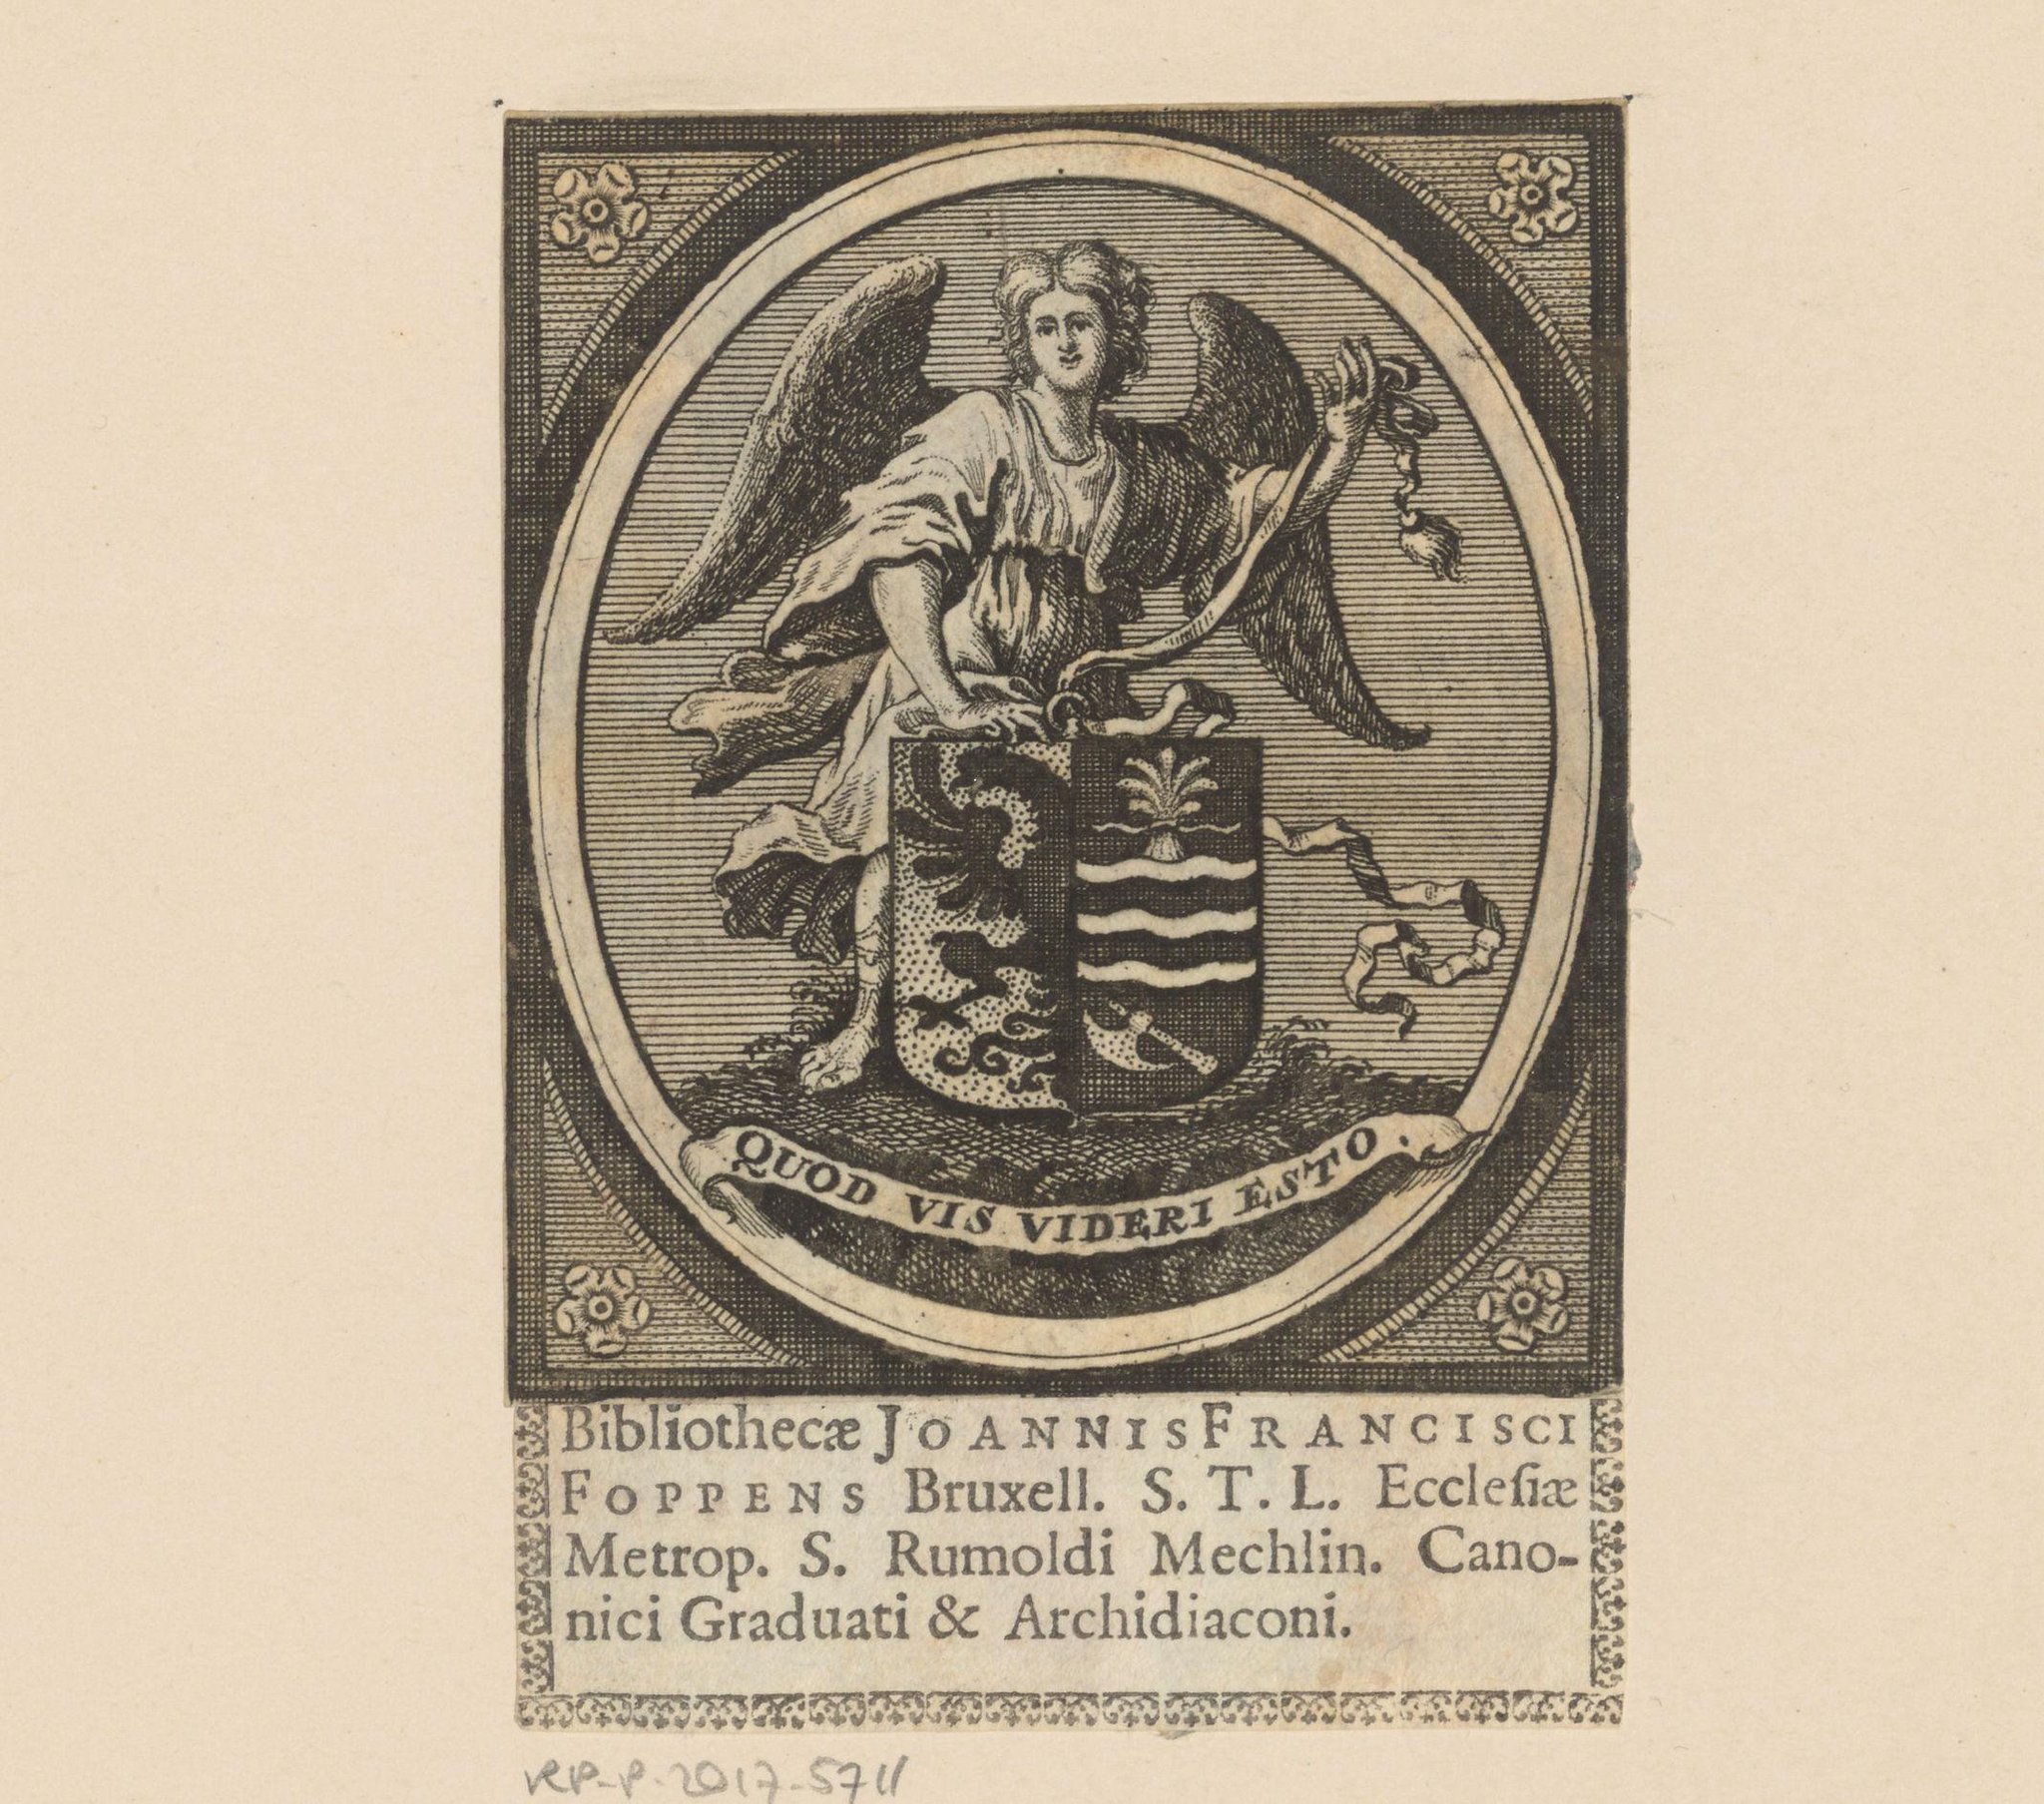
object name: bookplate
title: Ex libris van Jean-François Foppens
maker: Anonymous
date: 1699-1761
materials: paper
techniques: etching, letterpress printing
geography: belgium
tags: brussels, mechelen, angels, armorial bearing, heraldry